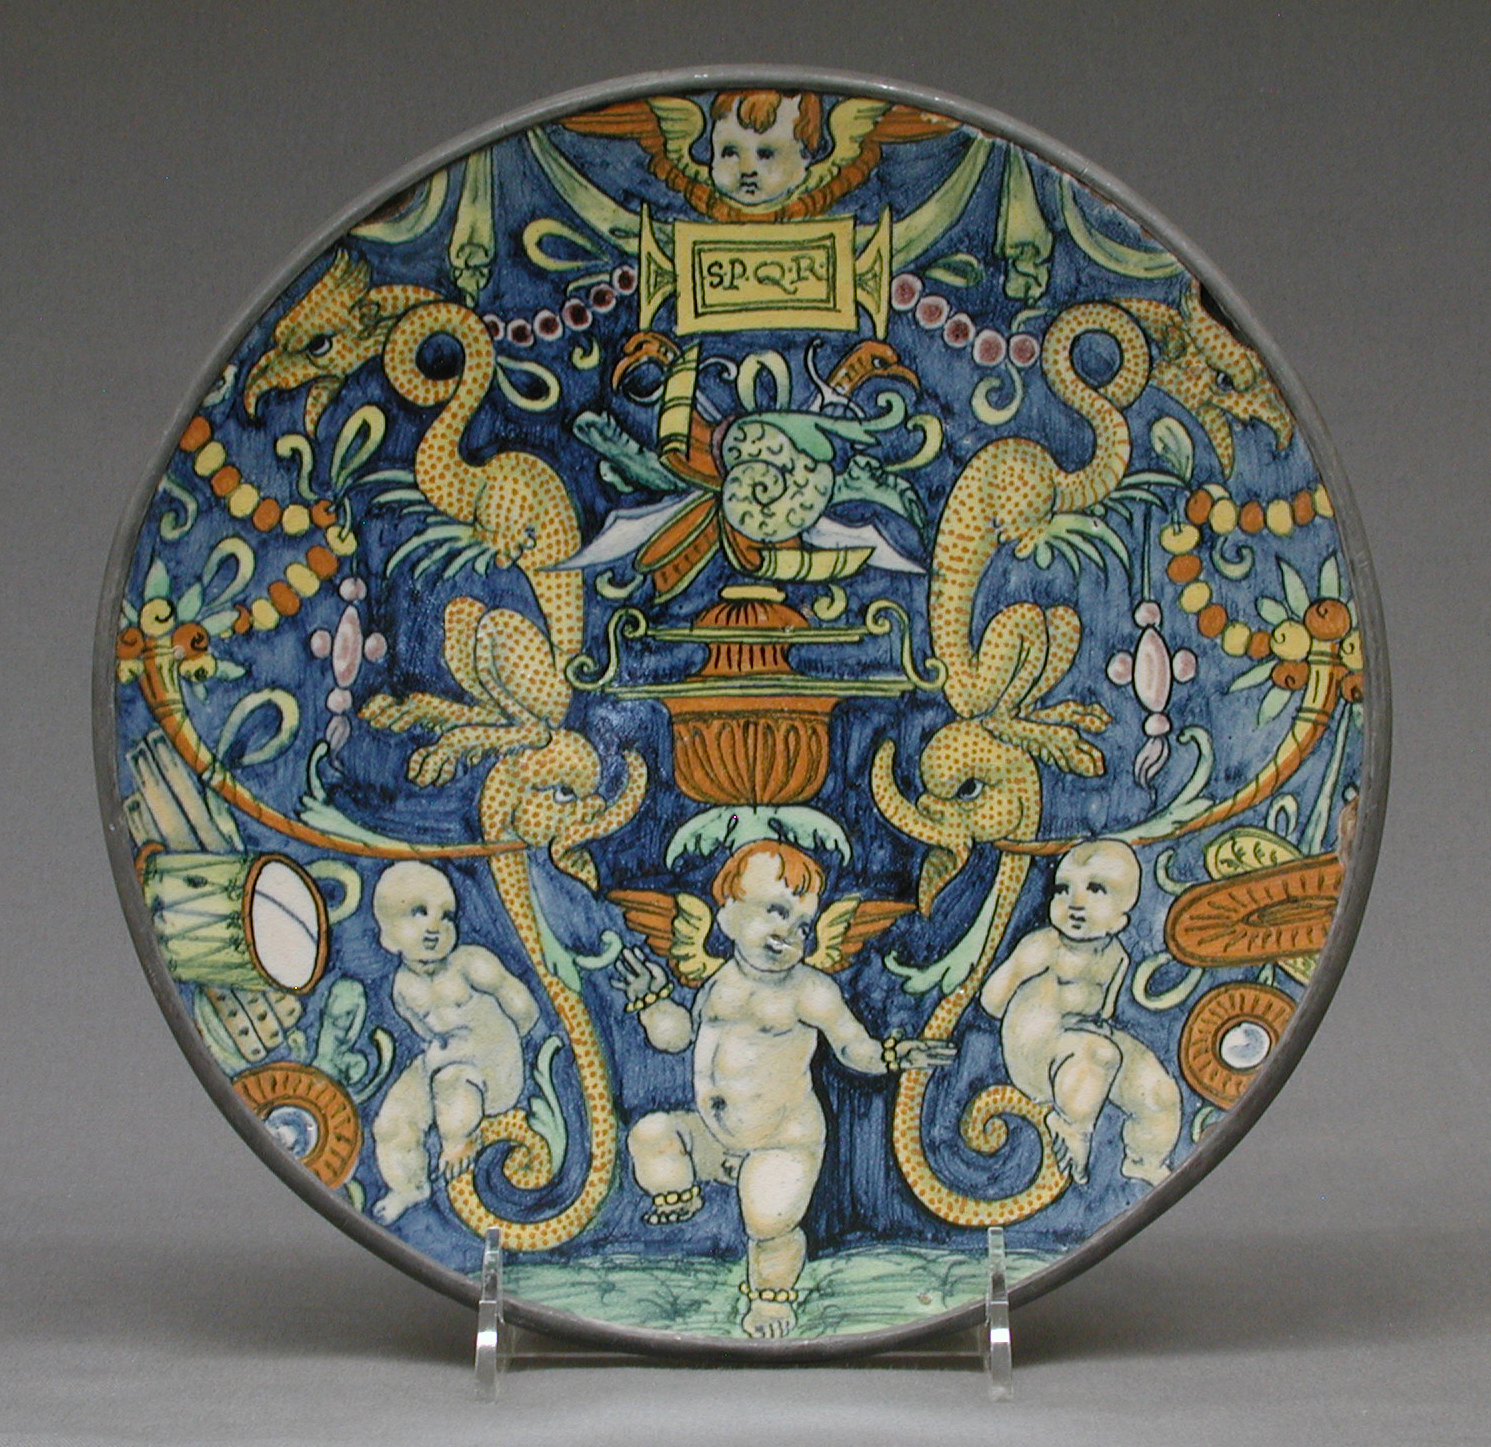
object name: plate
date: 1525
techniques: maiolica, glazing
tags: griffins,putti